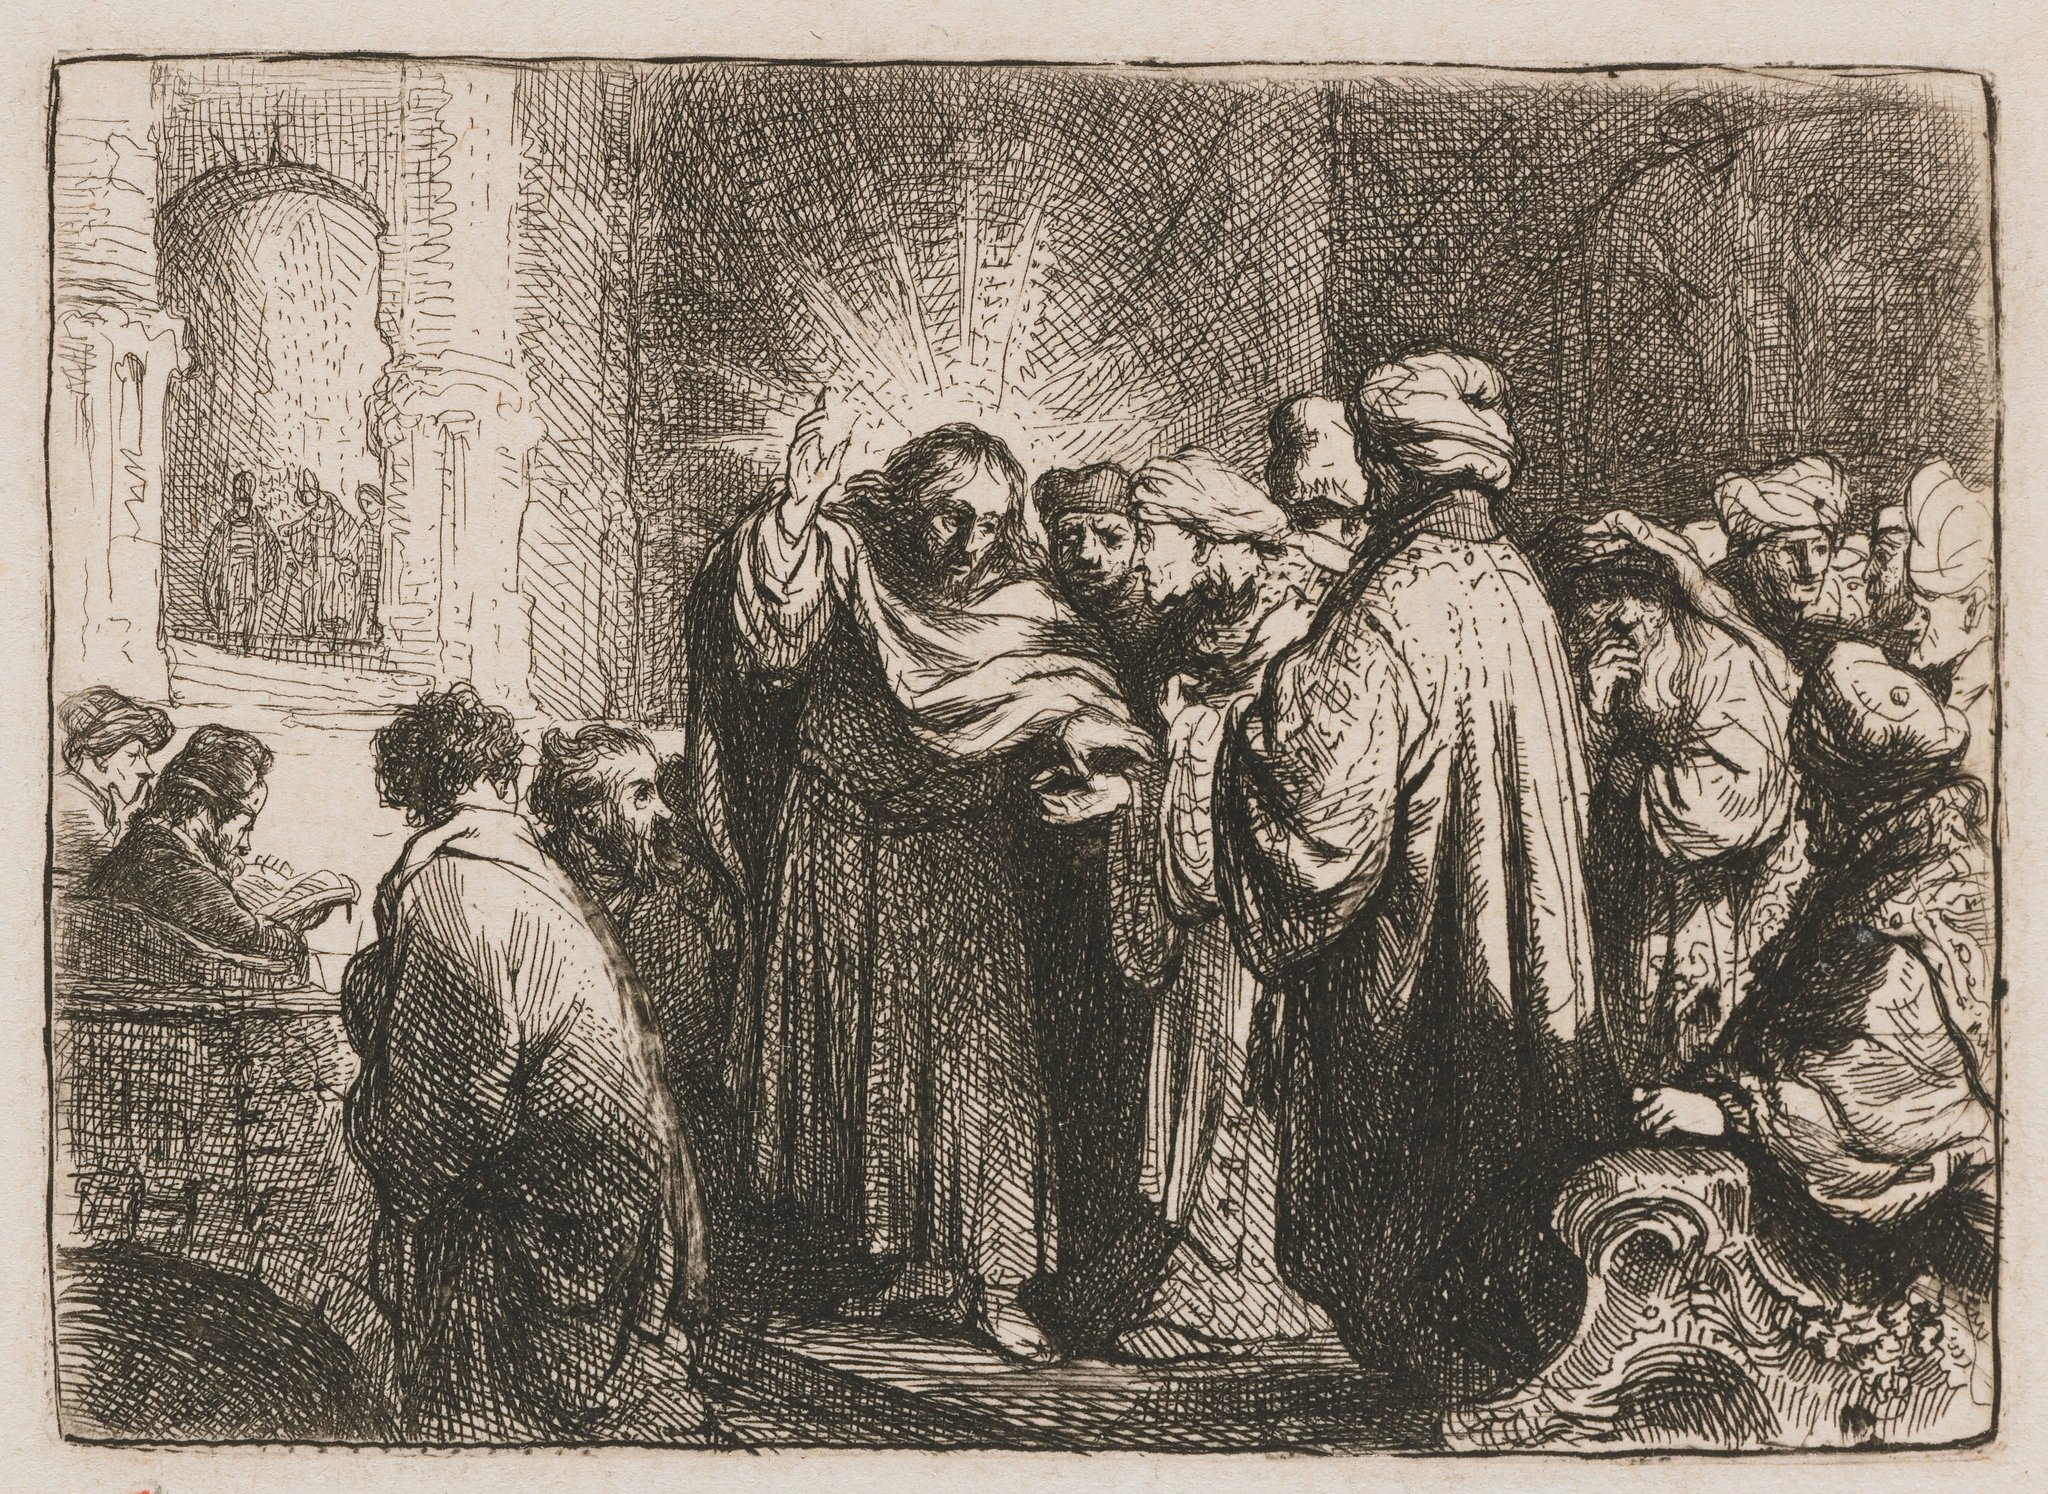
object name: print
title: The Tribute Money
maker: rembrandt van rijn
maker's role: draughtsman, painter, print maker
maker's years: 1606-1669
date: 1634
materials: paper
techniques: etching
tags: christ discussing the temple tribute with the apostles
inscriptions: collector's mark: Lugt 240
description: The Pharisees wanted to know from Christ whether Jewish law allowed taxes to be paid to the emperor. He saw through the trick question and asked who was depicted on a Roman coin: the emperor. Whereupon he said: ‘render unto Caesar the things that are Caesar’s, and unto God the things that are God’s’. Rembrandt hints here that the men have dubious intentions.